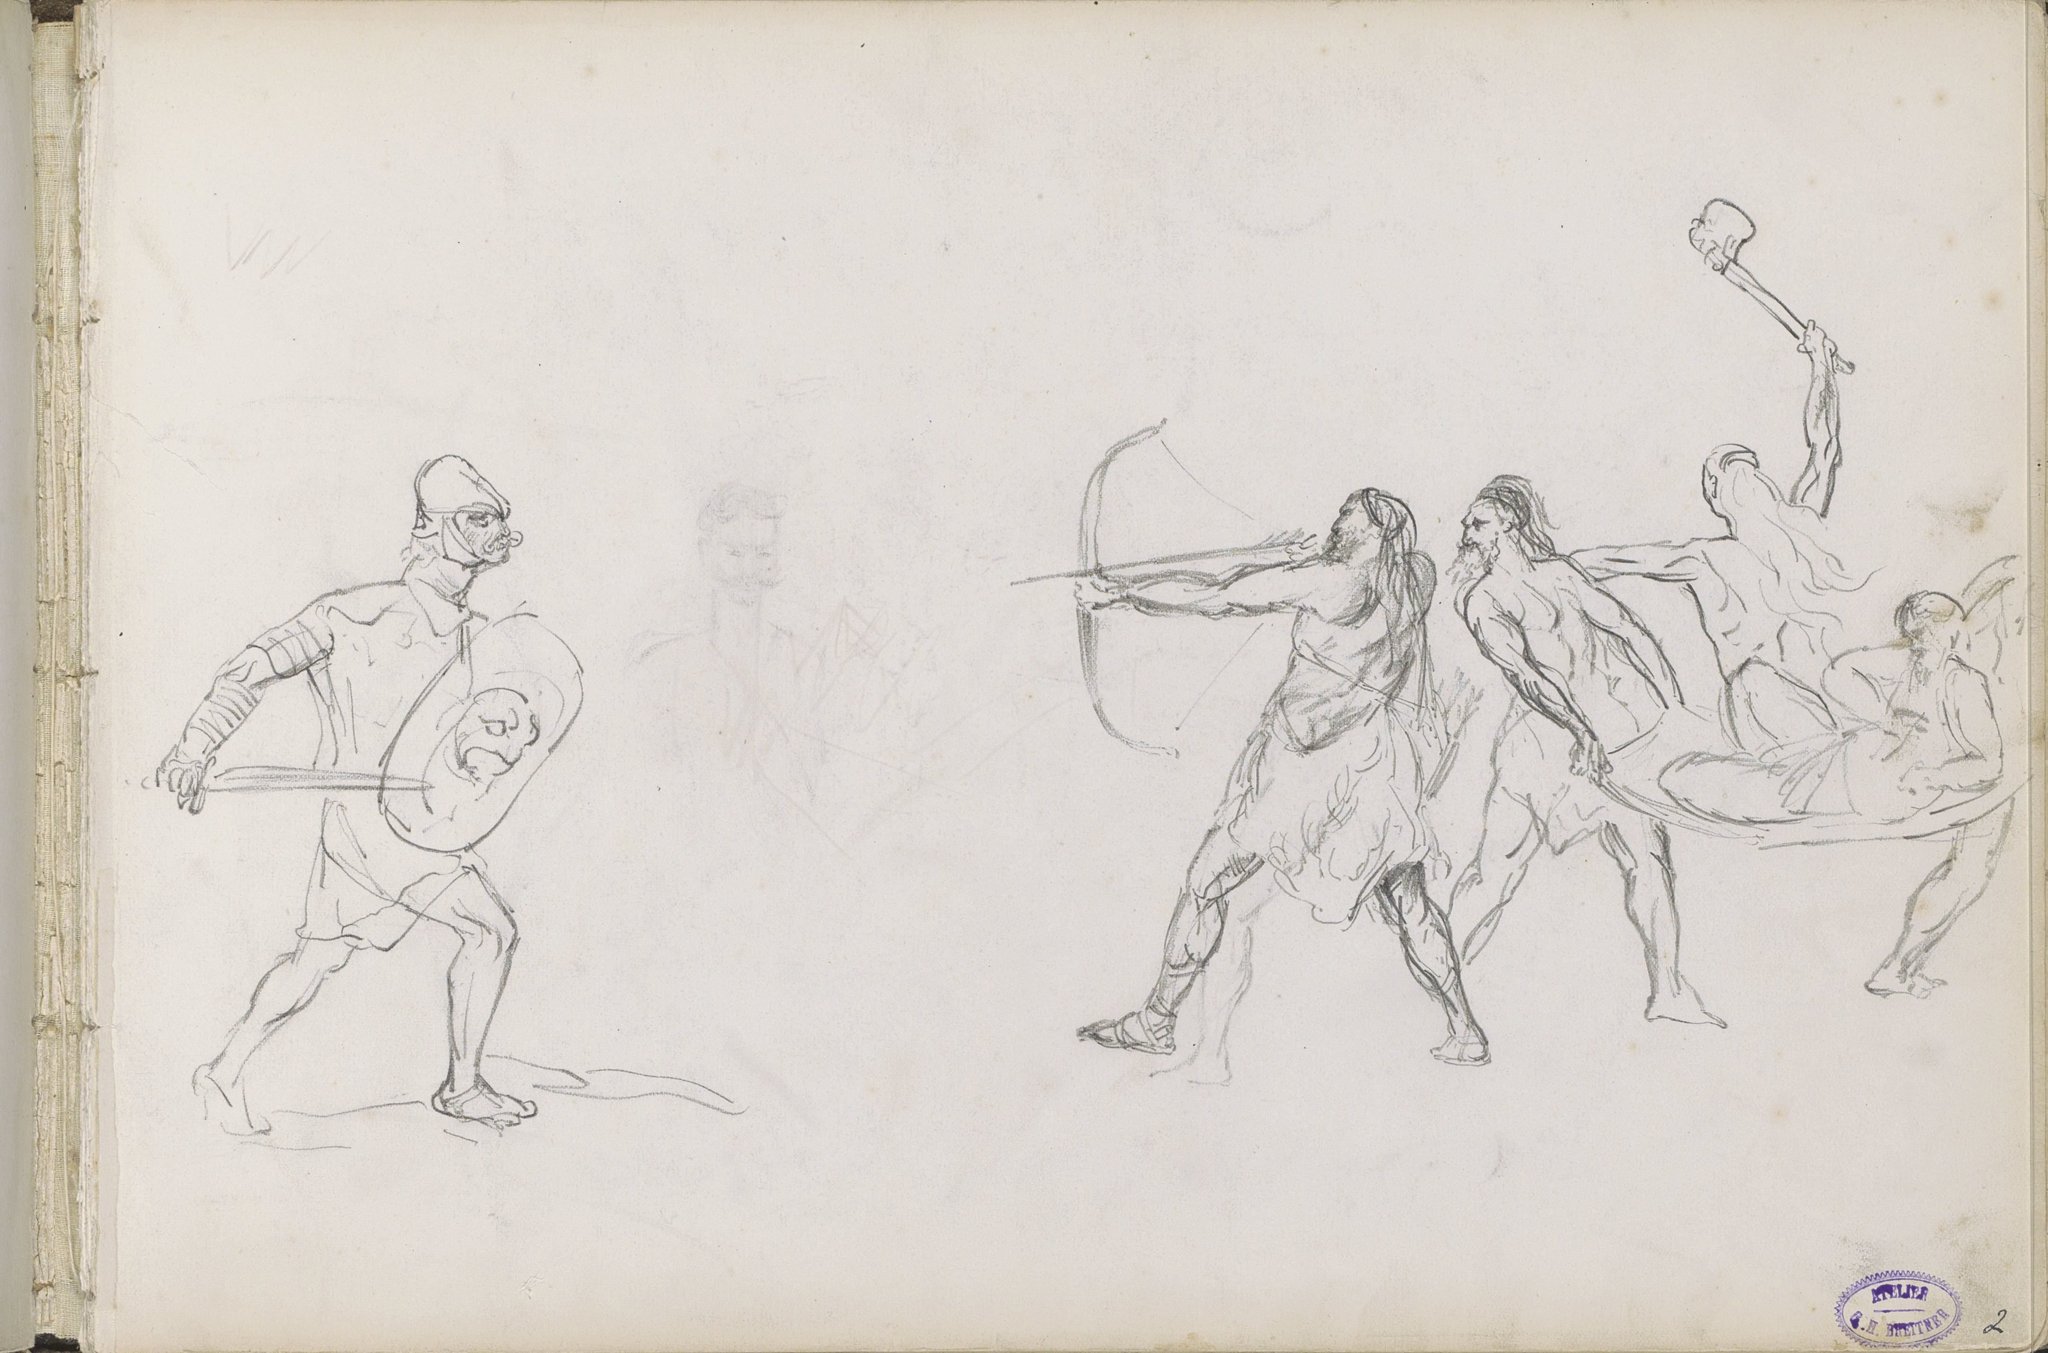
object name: sketchbook leaf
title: Gevecht tussen een soldaat met een zwaard en twee mannen met een bijl en een pijl en boog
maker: george hendrik breitner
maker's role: draughtsman, painter, print maker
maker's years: 1857-1923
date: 1873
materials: paper, pencil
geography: rotterdam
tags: (carrying a person on a) litter, stretcher, division of armed forces (+ during the battle)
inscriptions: workshop stamp: Lugt 291d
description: Twee mannen voeren mogelijk een gewonde weg. Blad 2 recto uit een schetsboek met 25 bladen.